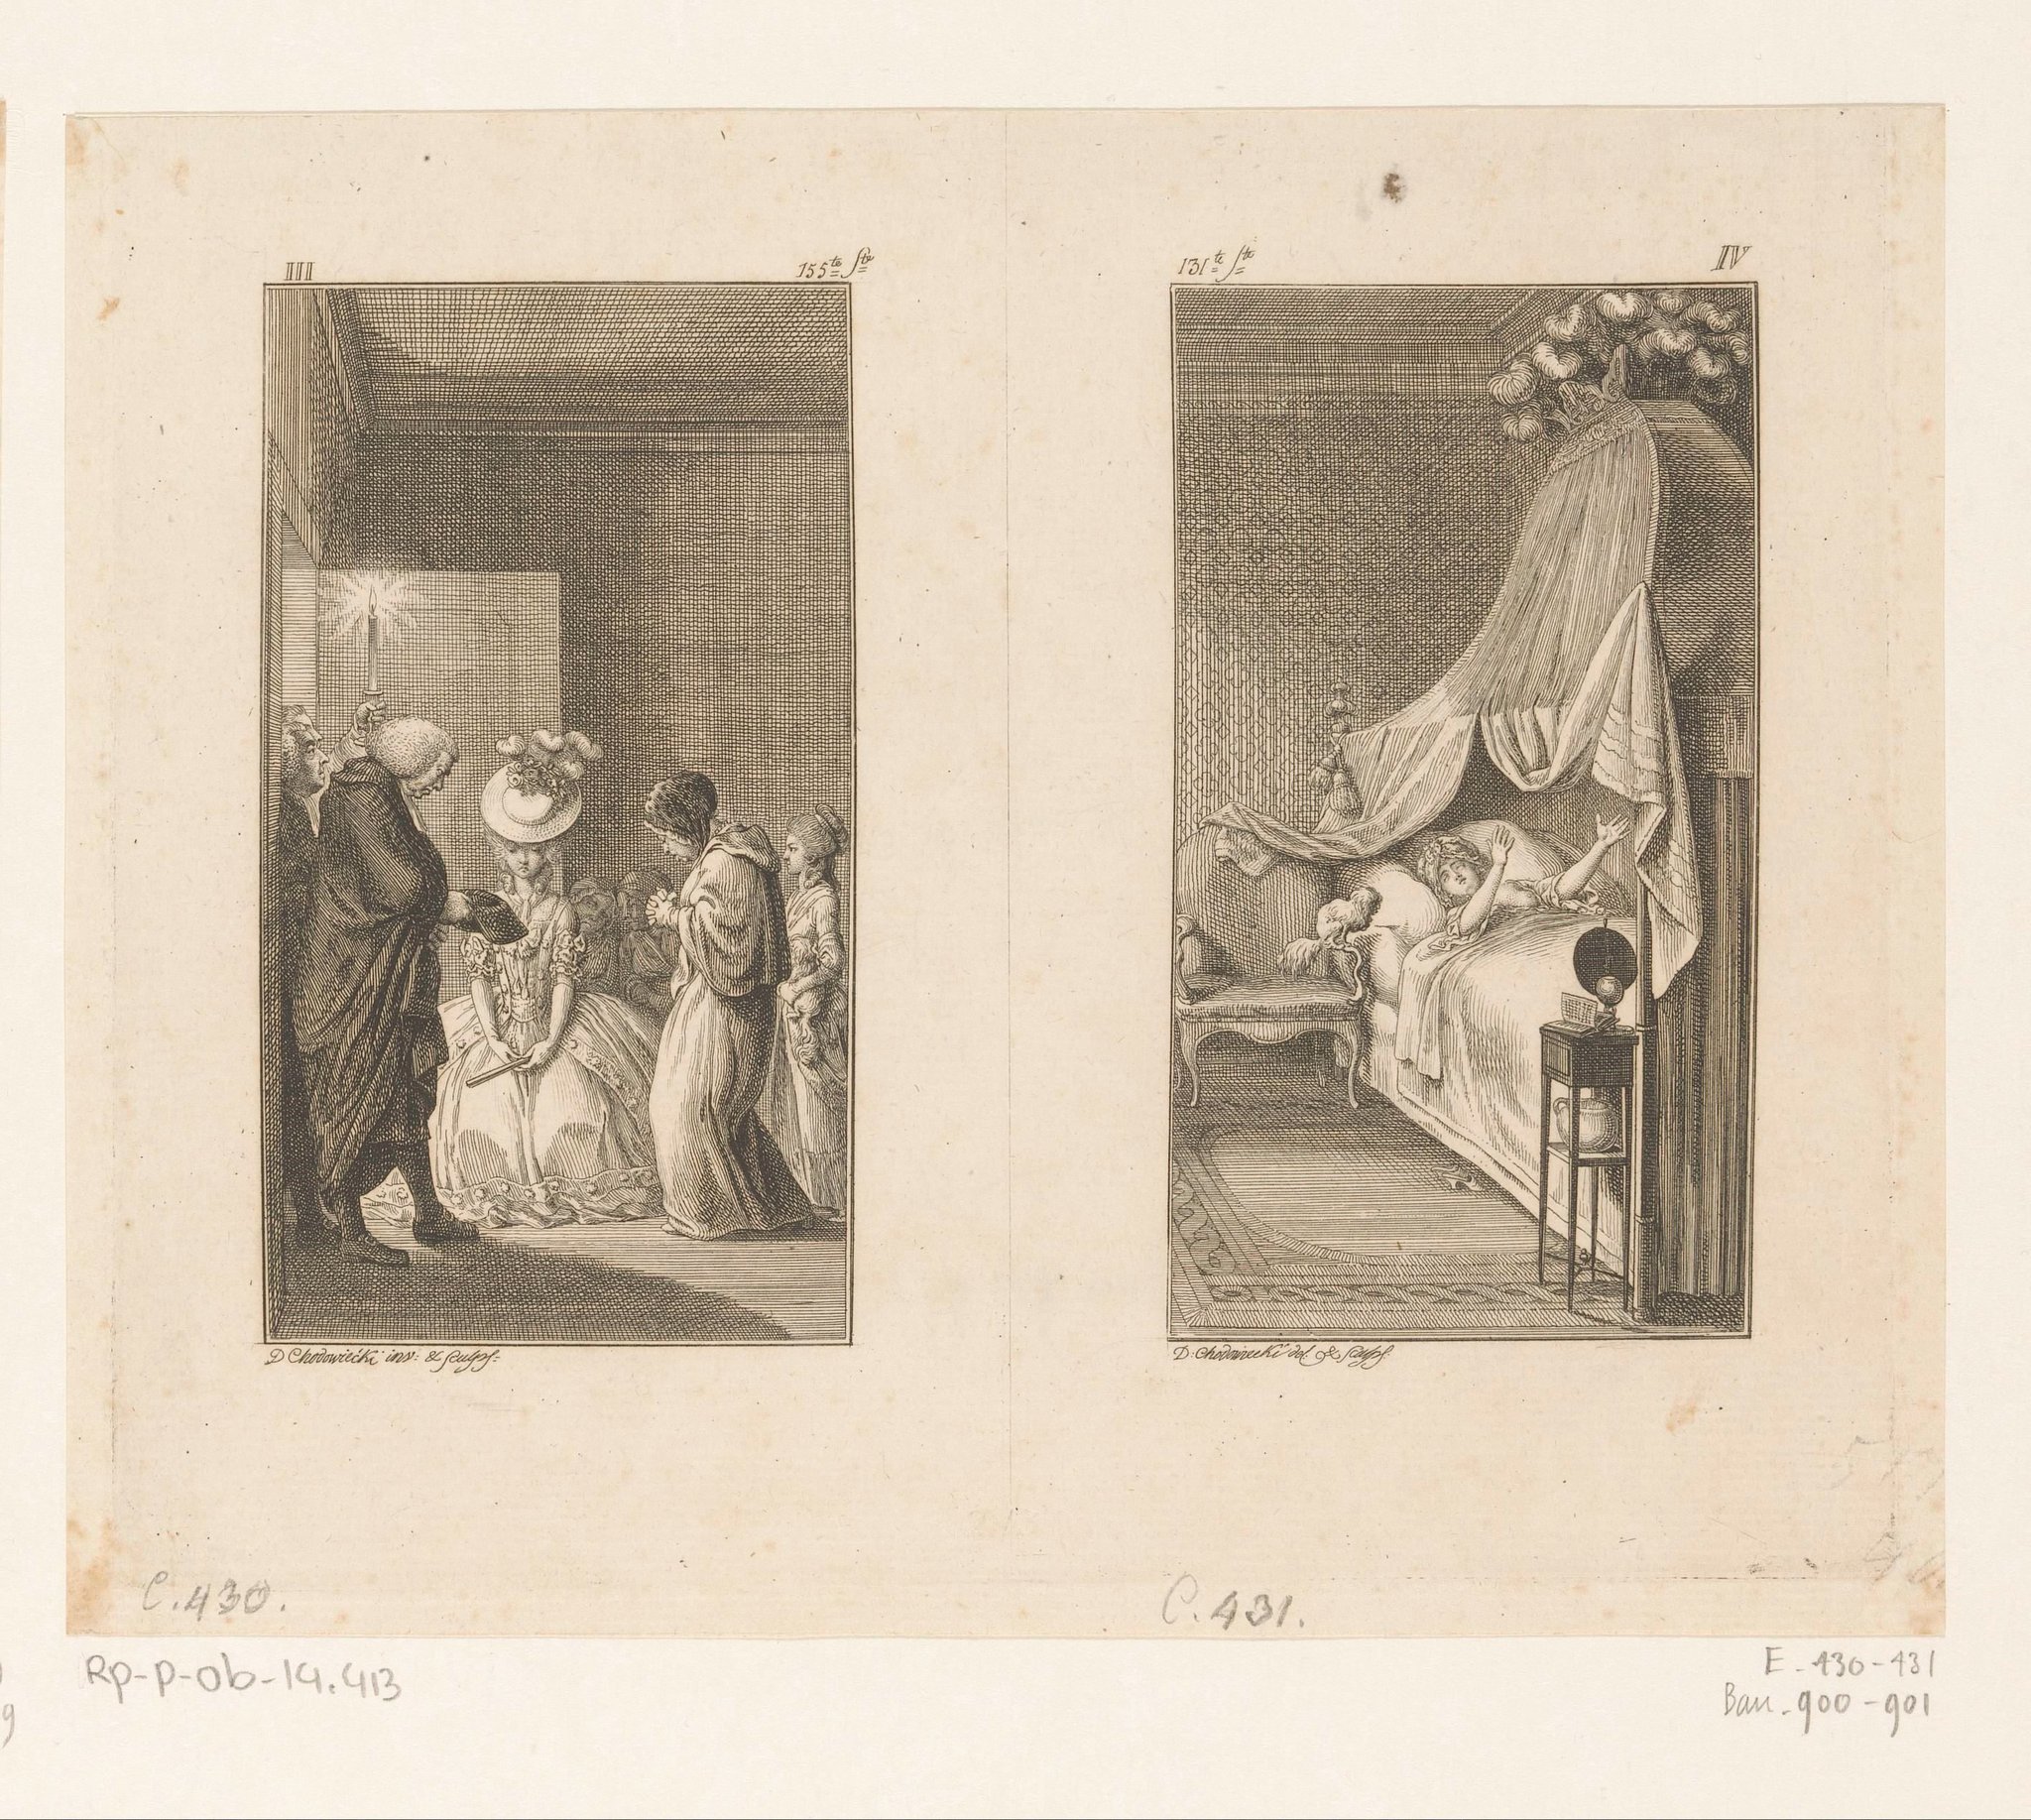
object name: book illustration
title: Twee voorstellingen uit Der kleiner Cäsar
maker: daniel nikolaus chodowiecki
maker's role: draughtsman, print maker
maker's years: 1726-1801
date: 1782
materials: paper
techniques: etching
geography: berlin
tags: bed, dog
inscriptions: collector's mark: Lugt 2228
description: Prent gebruikt voor: Coventry, Francis. Der kleine Cäsar (...). 2 dln. Leipzig: Dykischen Buchhandlung, 1782, dl. 1.